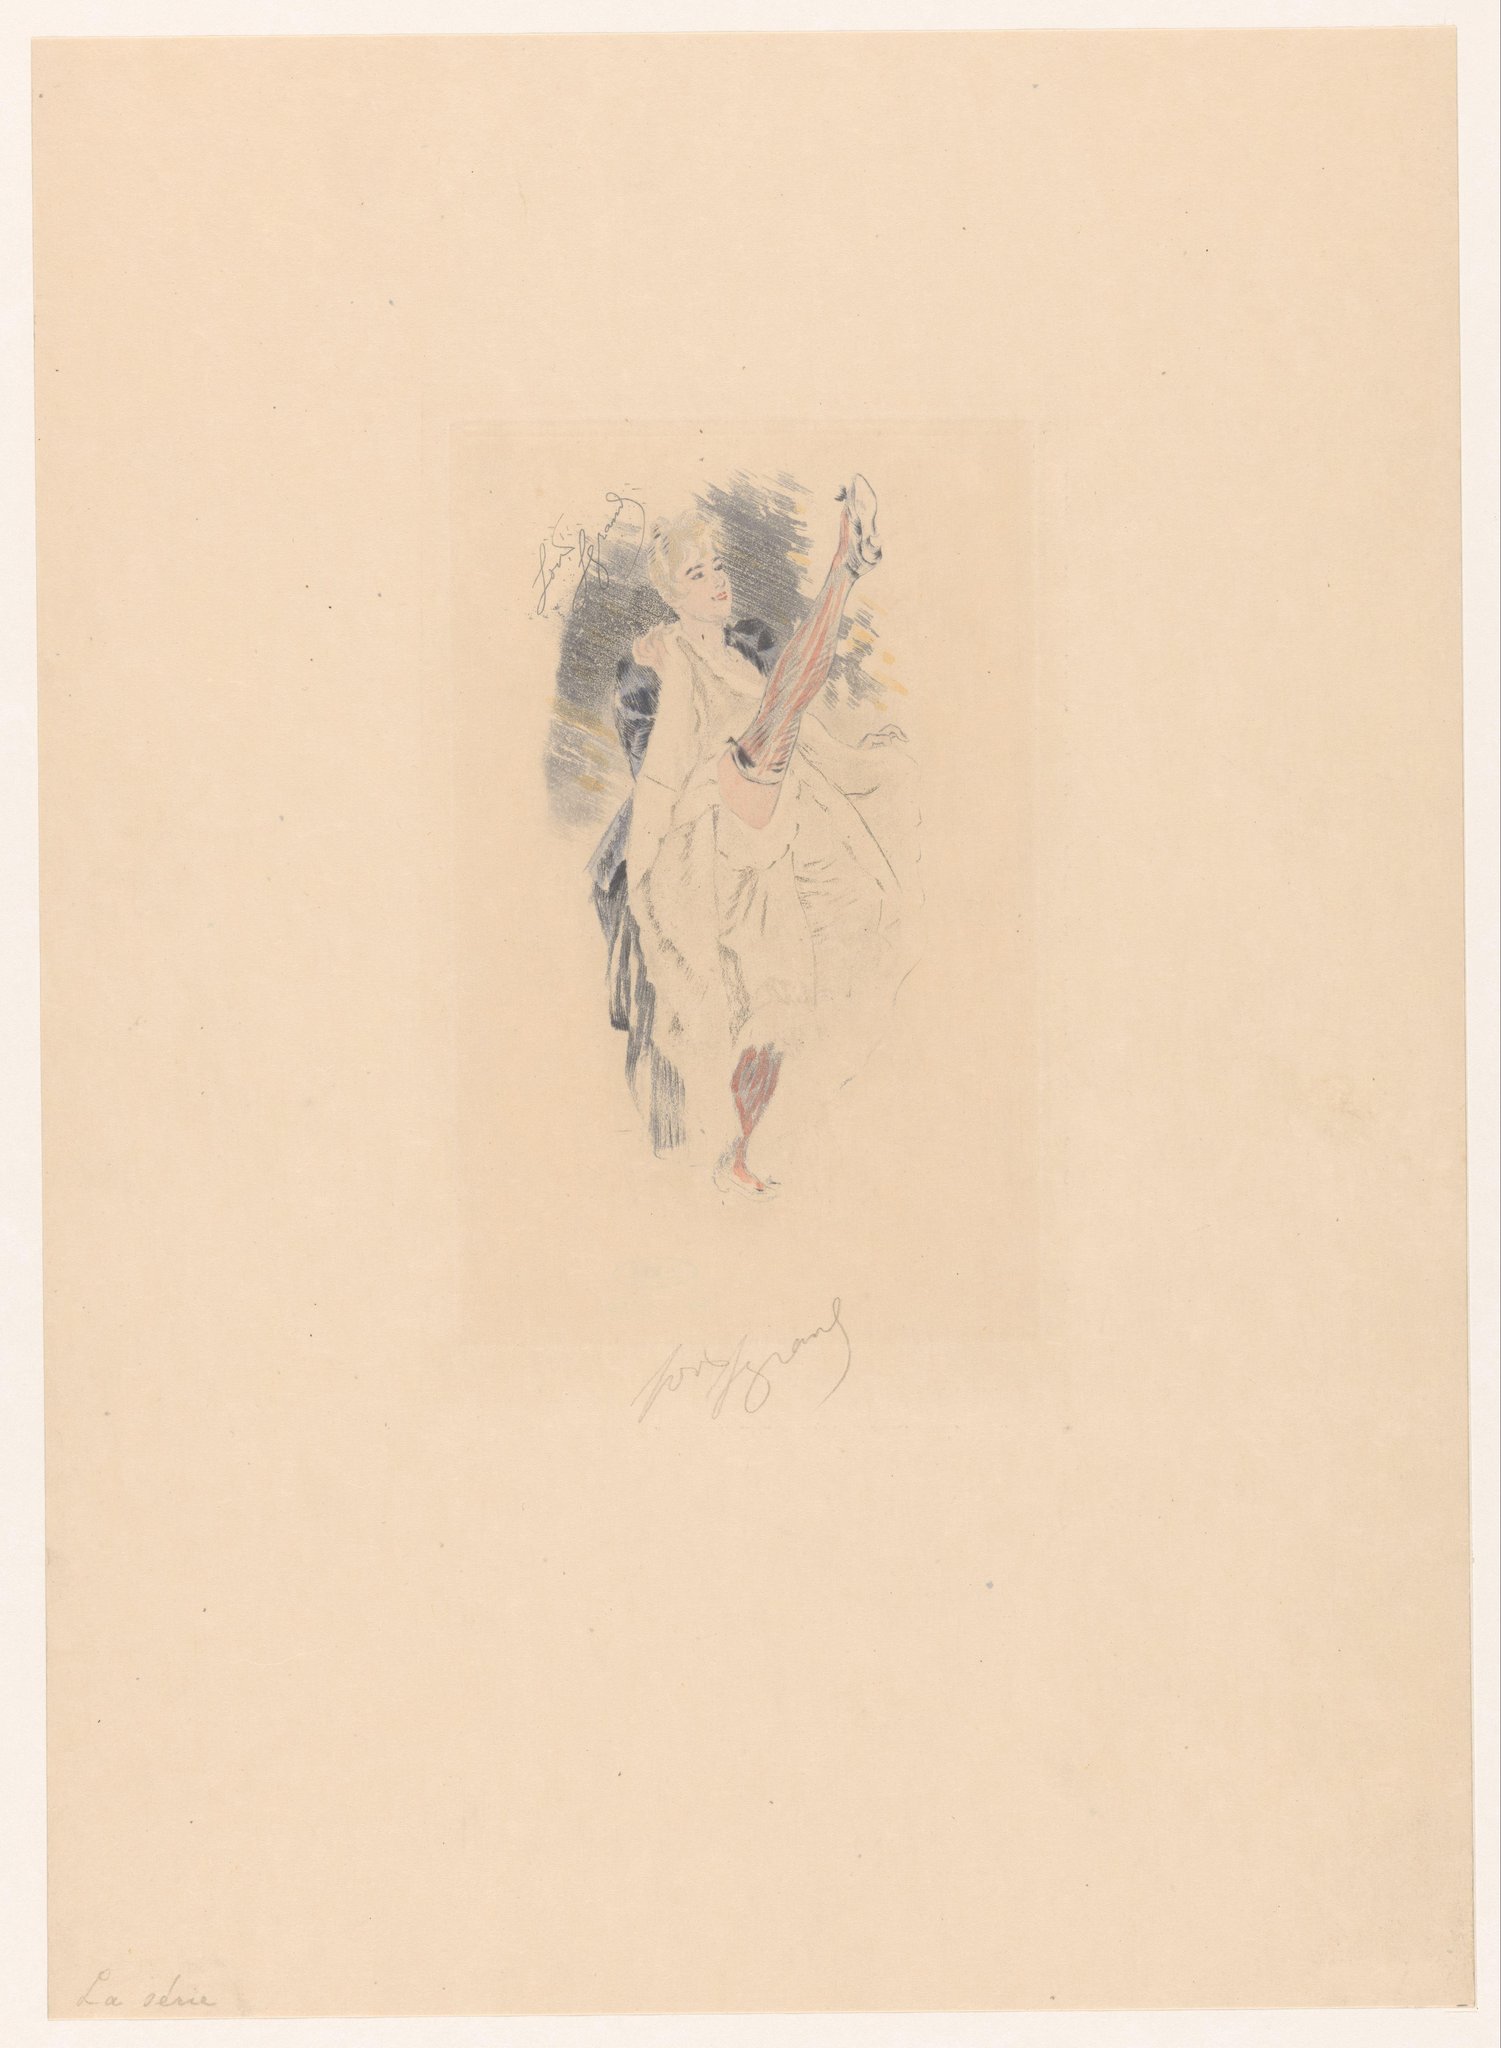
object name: print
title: Cancan-danseres met opgeheven been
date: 1892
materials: paper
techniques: drypoint, etching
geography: france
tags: female dancer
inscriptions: collector's mark: Lugt 2228, title: ‘La série’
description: Prent uit: Legrand, Louis. Cours de danse fin de siècle. Parijs: Edouard Dentu, 1892.